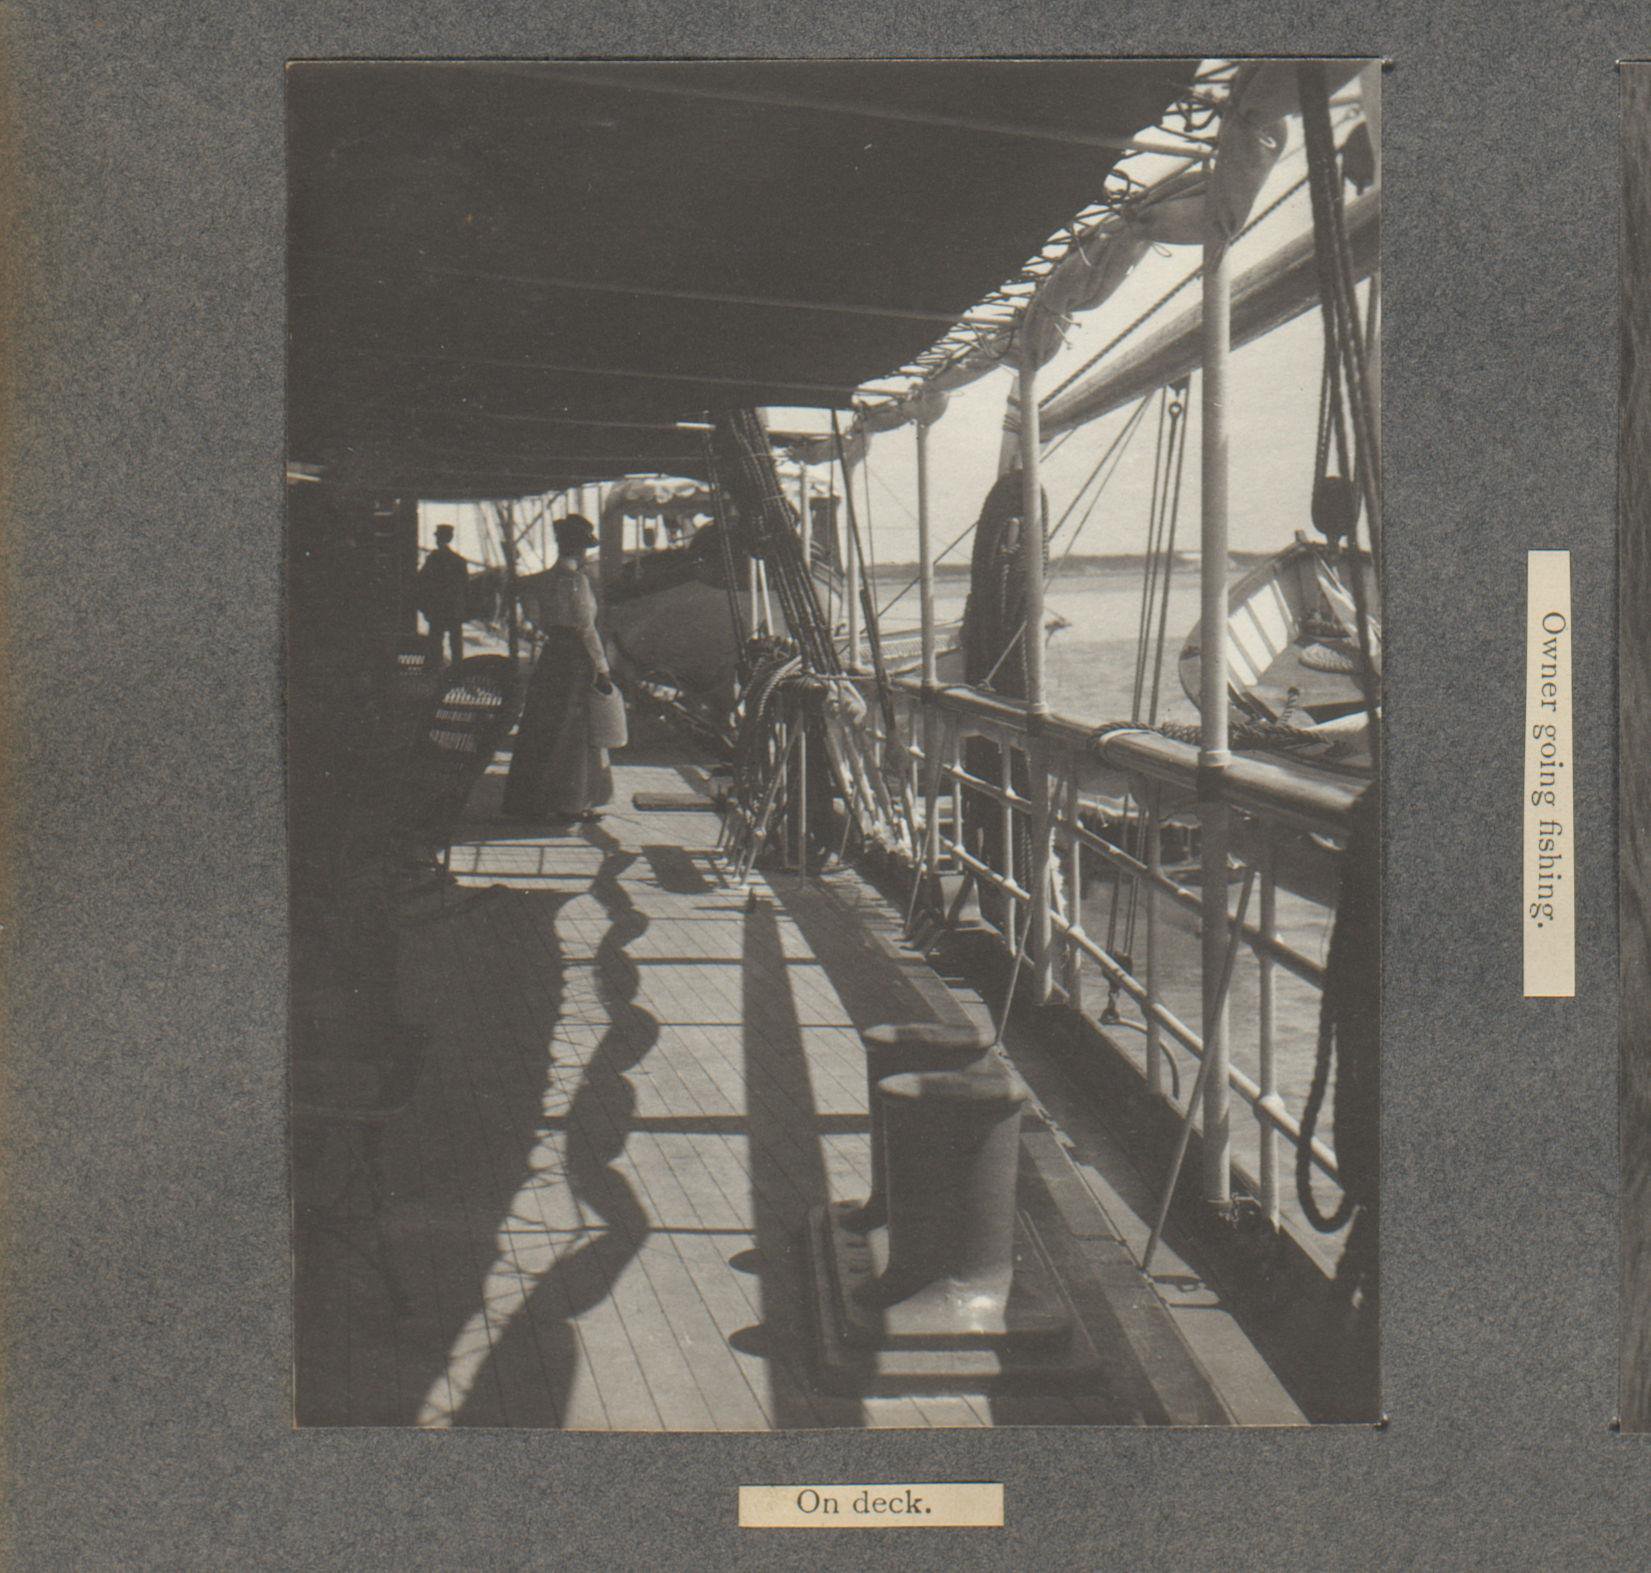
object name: photograph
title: Sloependek van de Columbia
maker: Anonymous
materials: paper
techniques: platinum process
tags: parts of ship's exterior